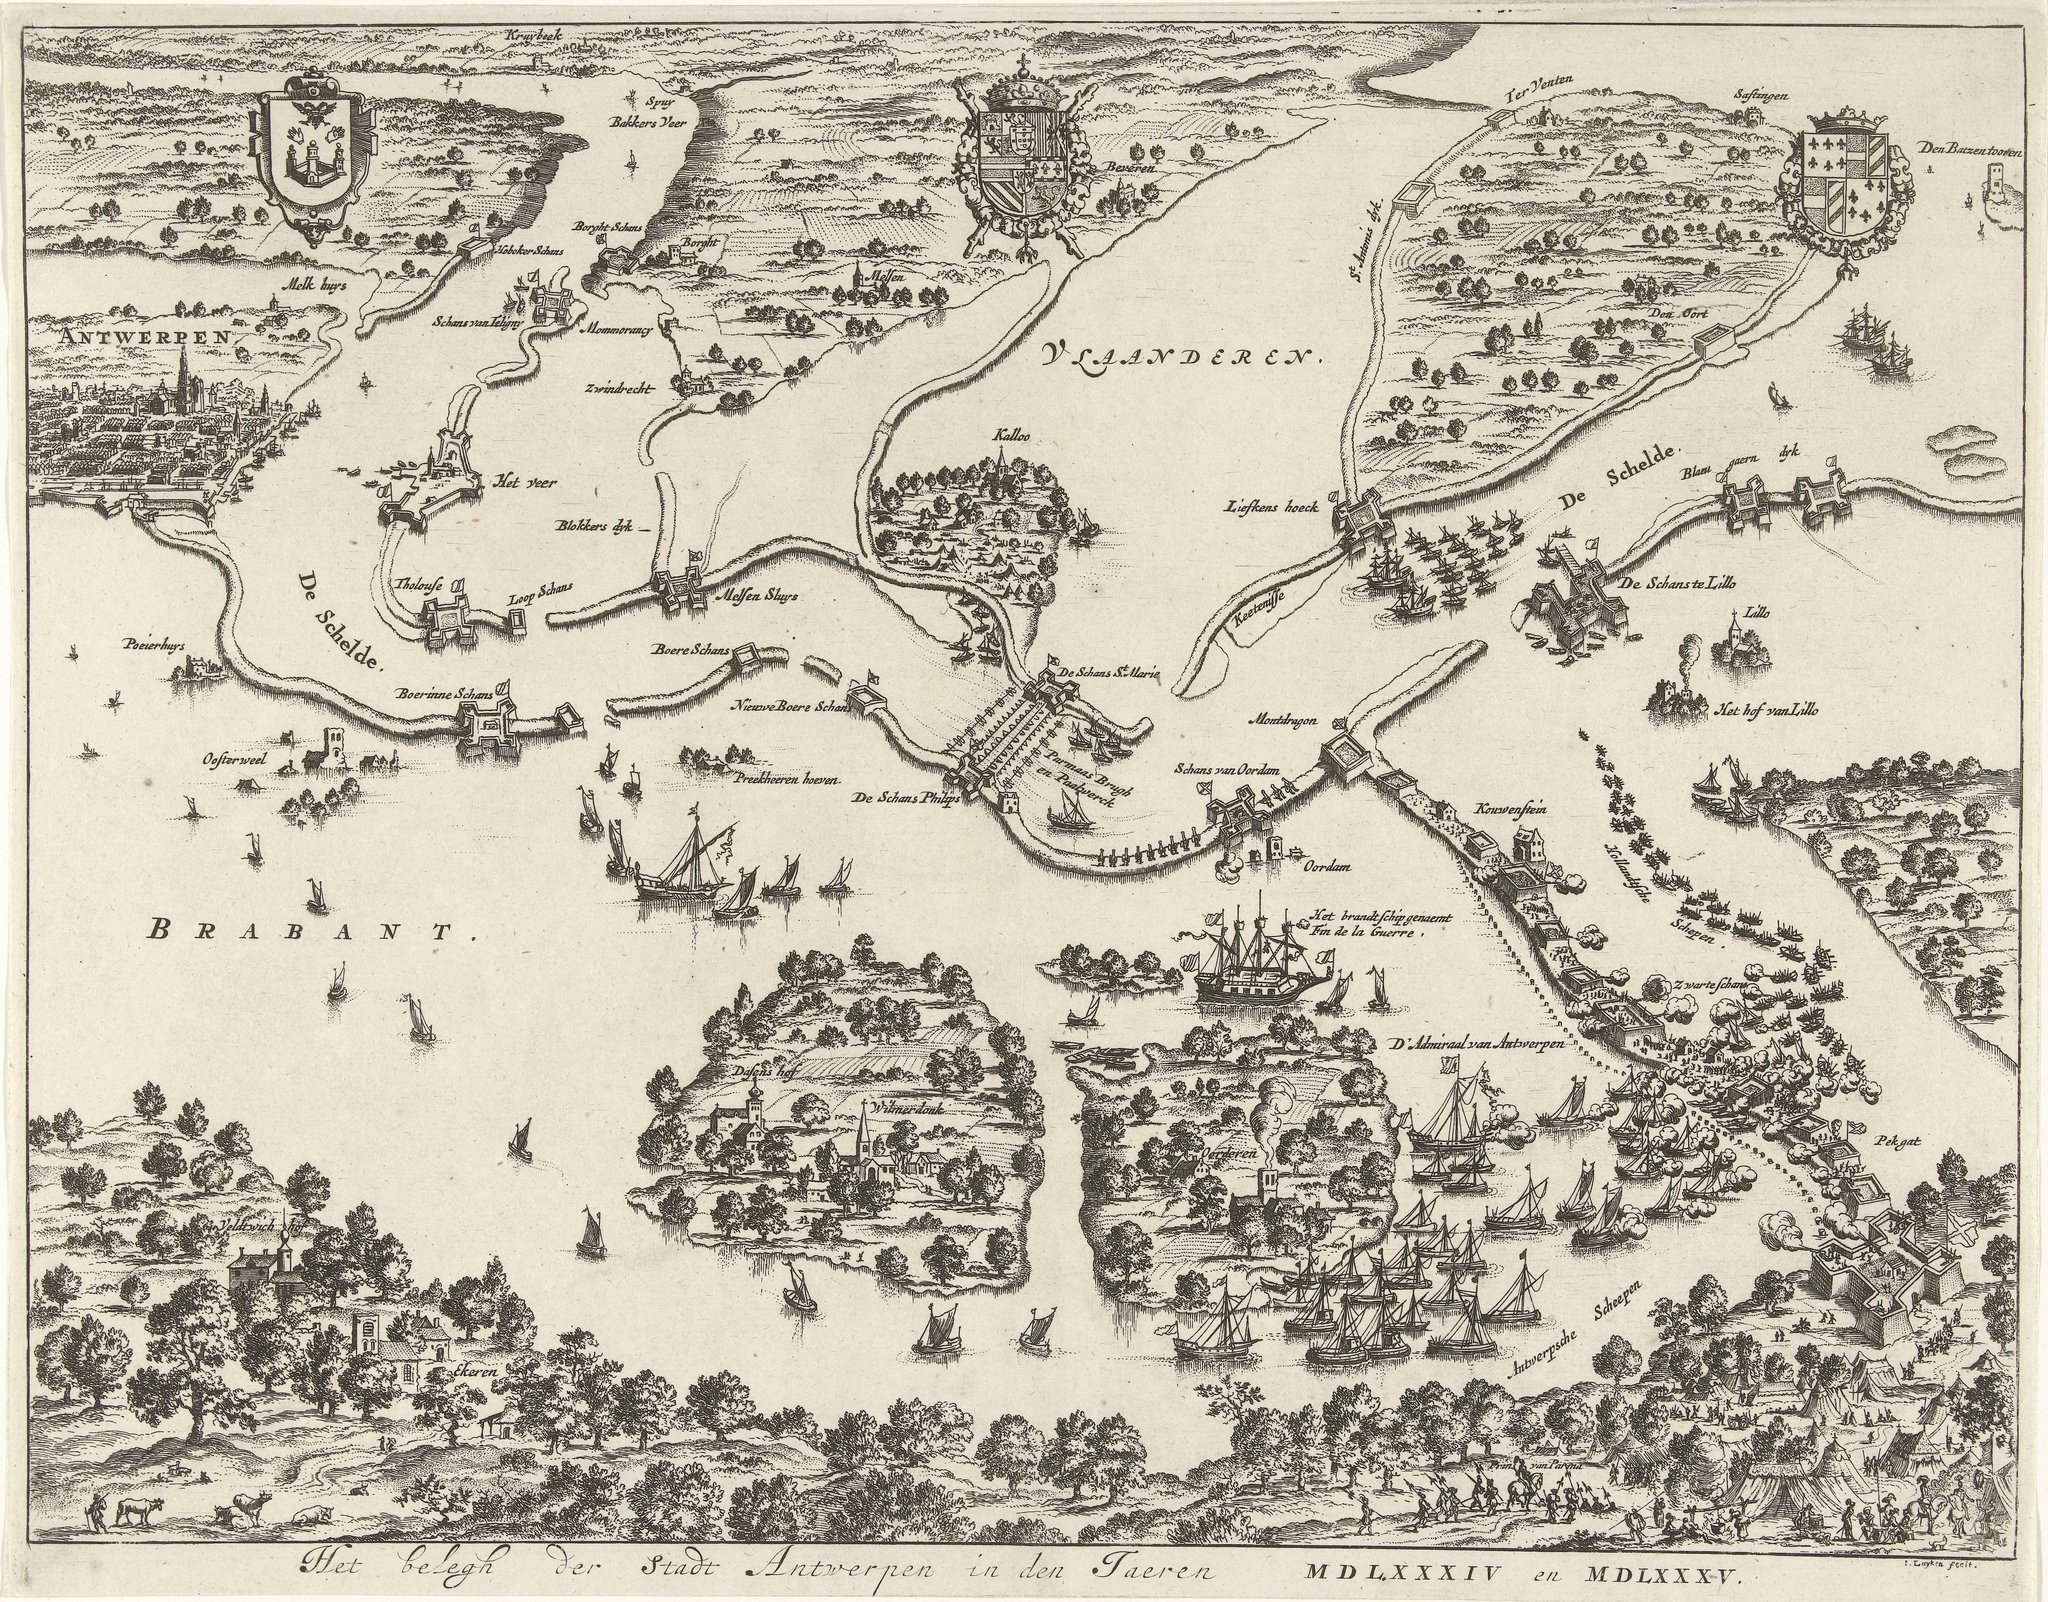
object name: history print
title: Het belegh der stadt Antwerpen in den jaeren MDLXXXIV en MDLXXXV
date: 1680-1684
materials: paper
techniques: engraving, etching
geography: amsterdam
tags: siege, position war, pontoon bridge, antwerp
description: Prent ook gebruikt in: Bor Christiaansz, Pieter. Oorsprongk, begin, en vervolgh der Nederlandsche oorlogen, 4 delen. Amsterdam: weduwe Joannes van Someren, Abraham Wolfgang, Hendrick en Dirk Boom, 1679-1684, dl. 2 (1680), p. 469. En in: Groot, Hugo de. Nederlandtsche Jaerboeken en Historien (…). Amsterdam: Wed. Joannes van Someren, Abraham Wolfgang en Hendrick en Dirk Boom, 1681, p. 98-99.